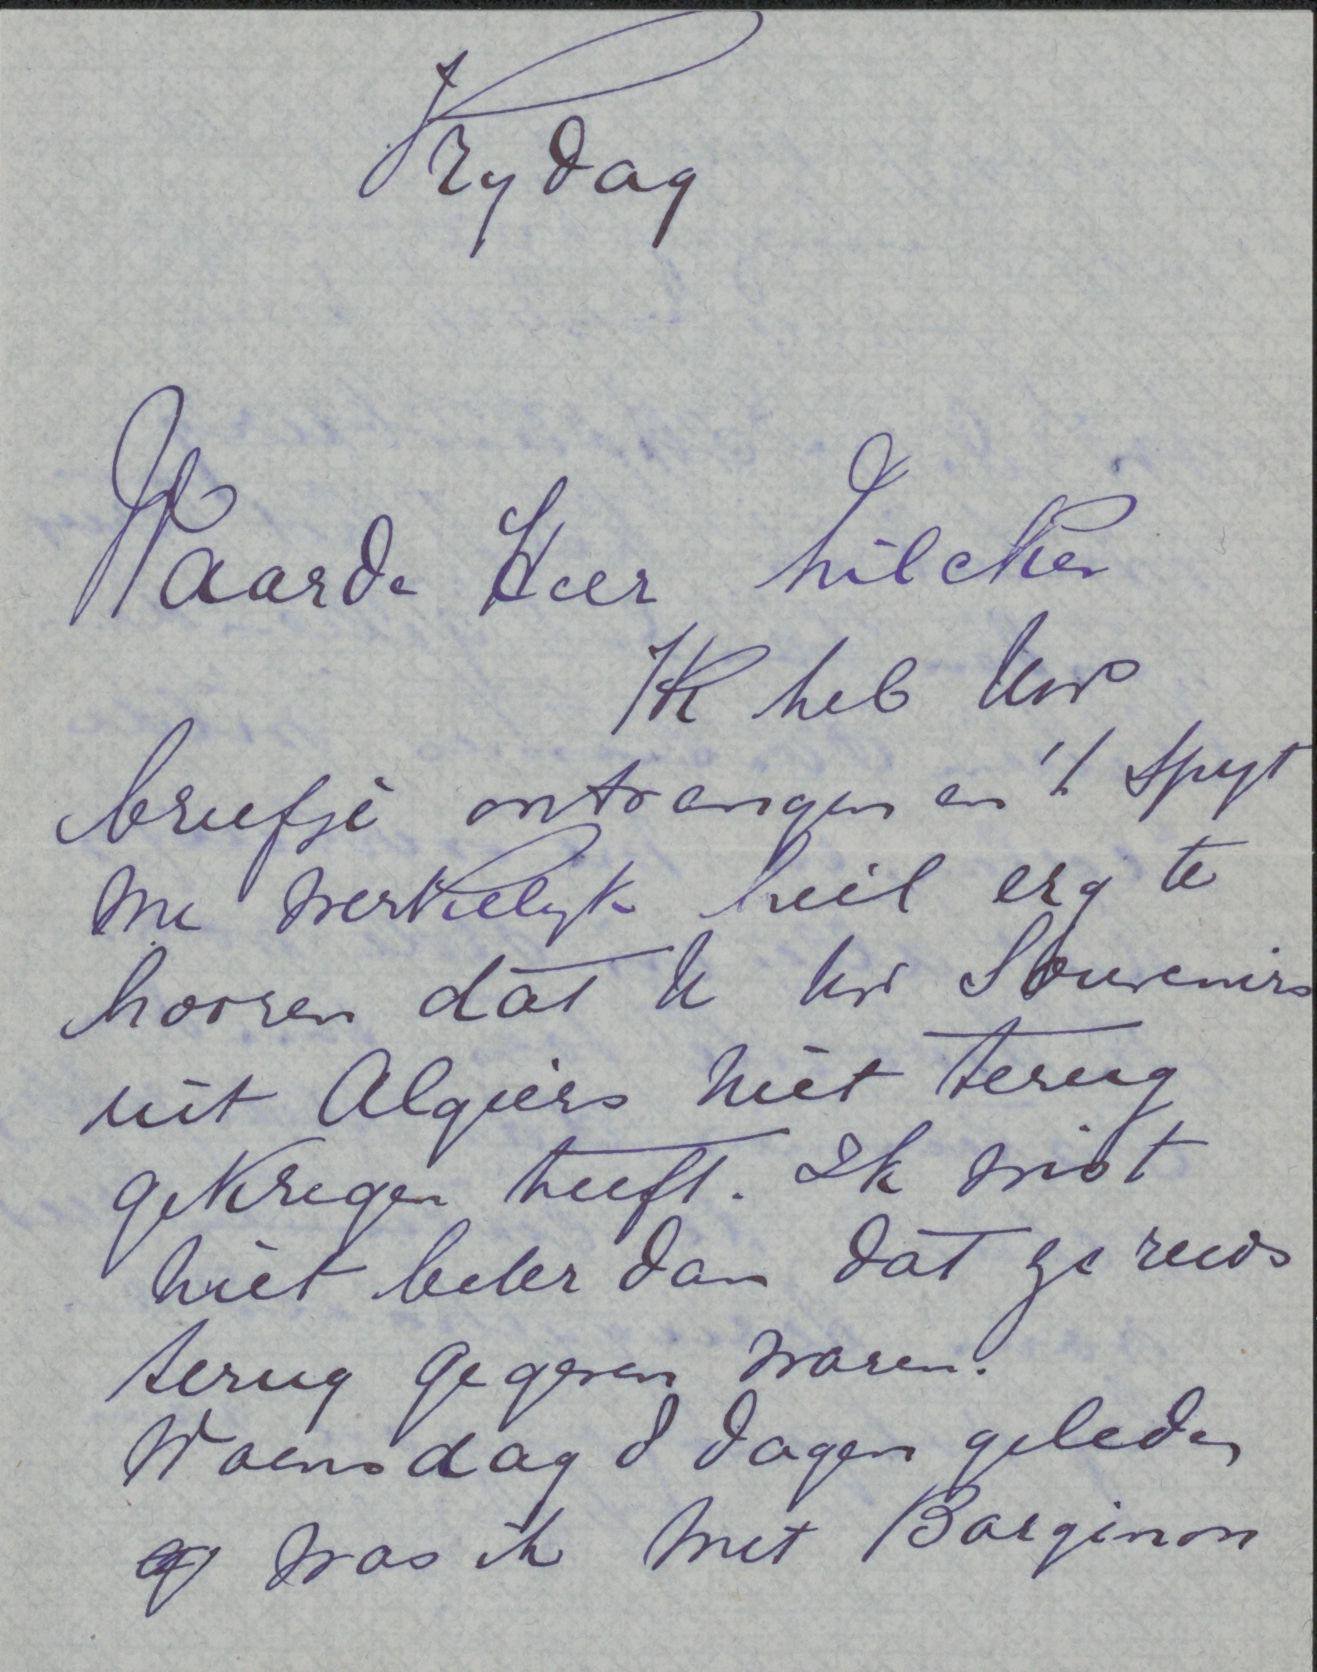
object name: letter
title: Brief aan Philip Zilcken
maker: carla van geuns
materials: ink, paper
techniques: pen, writing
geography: the hague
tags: the hague, painter, draughtsman, philip zilcken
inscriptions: collector's mark: ‘RPK’